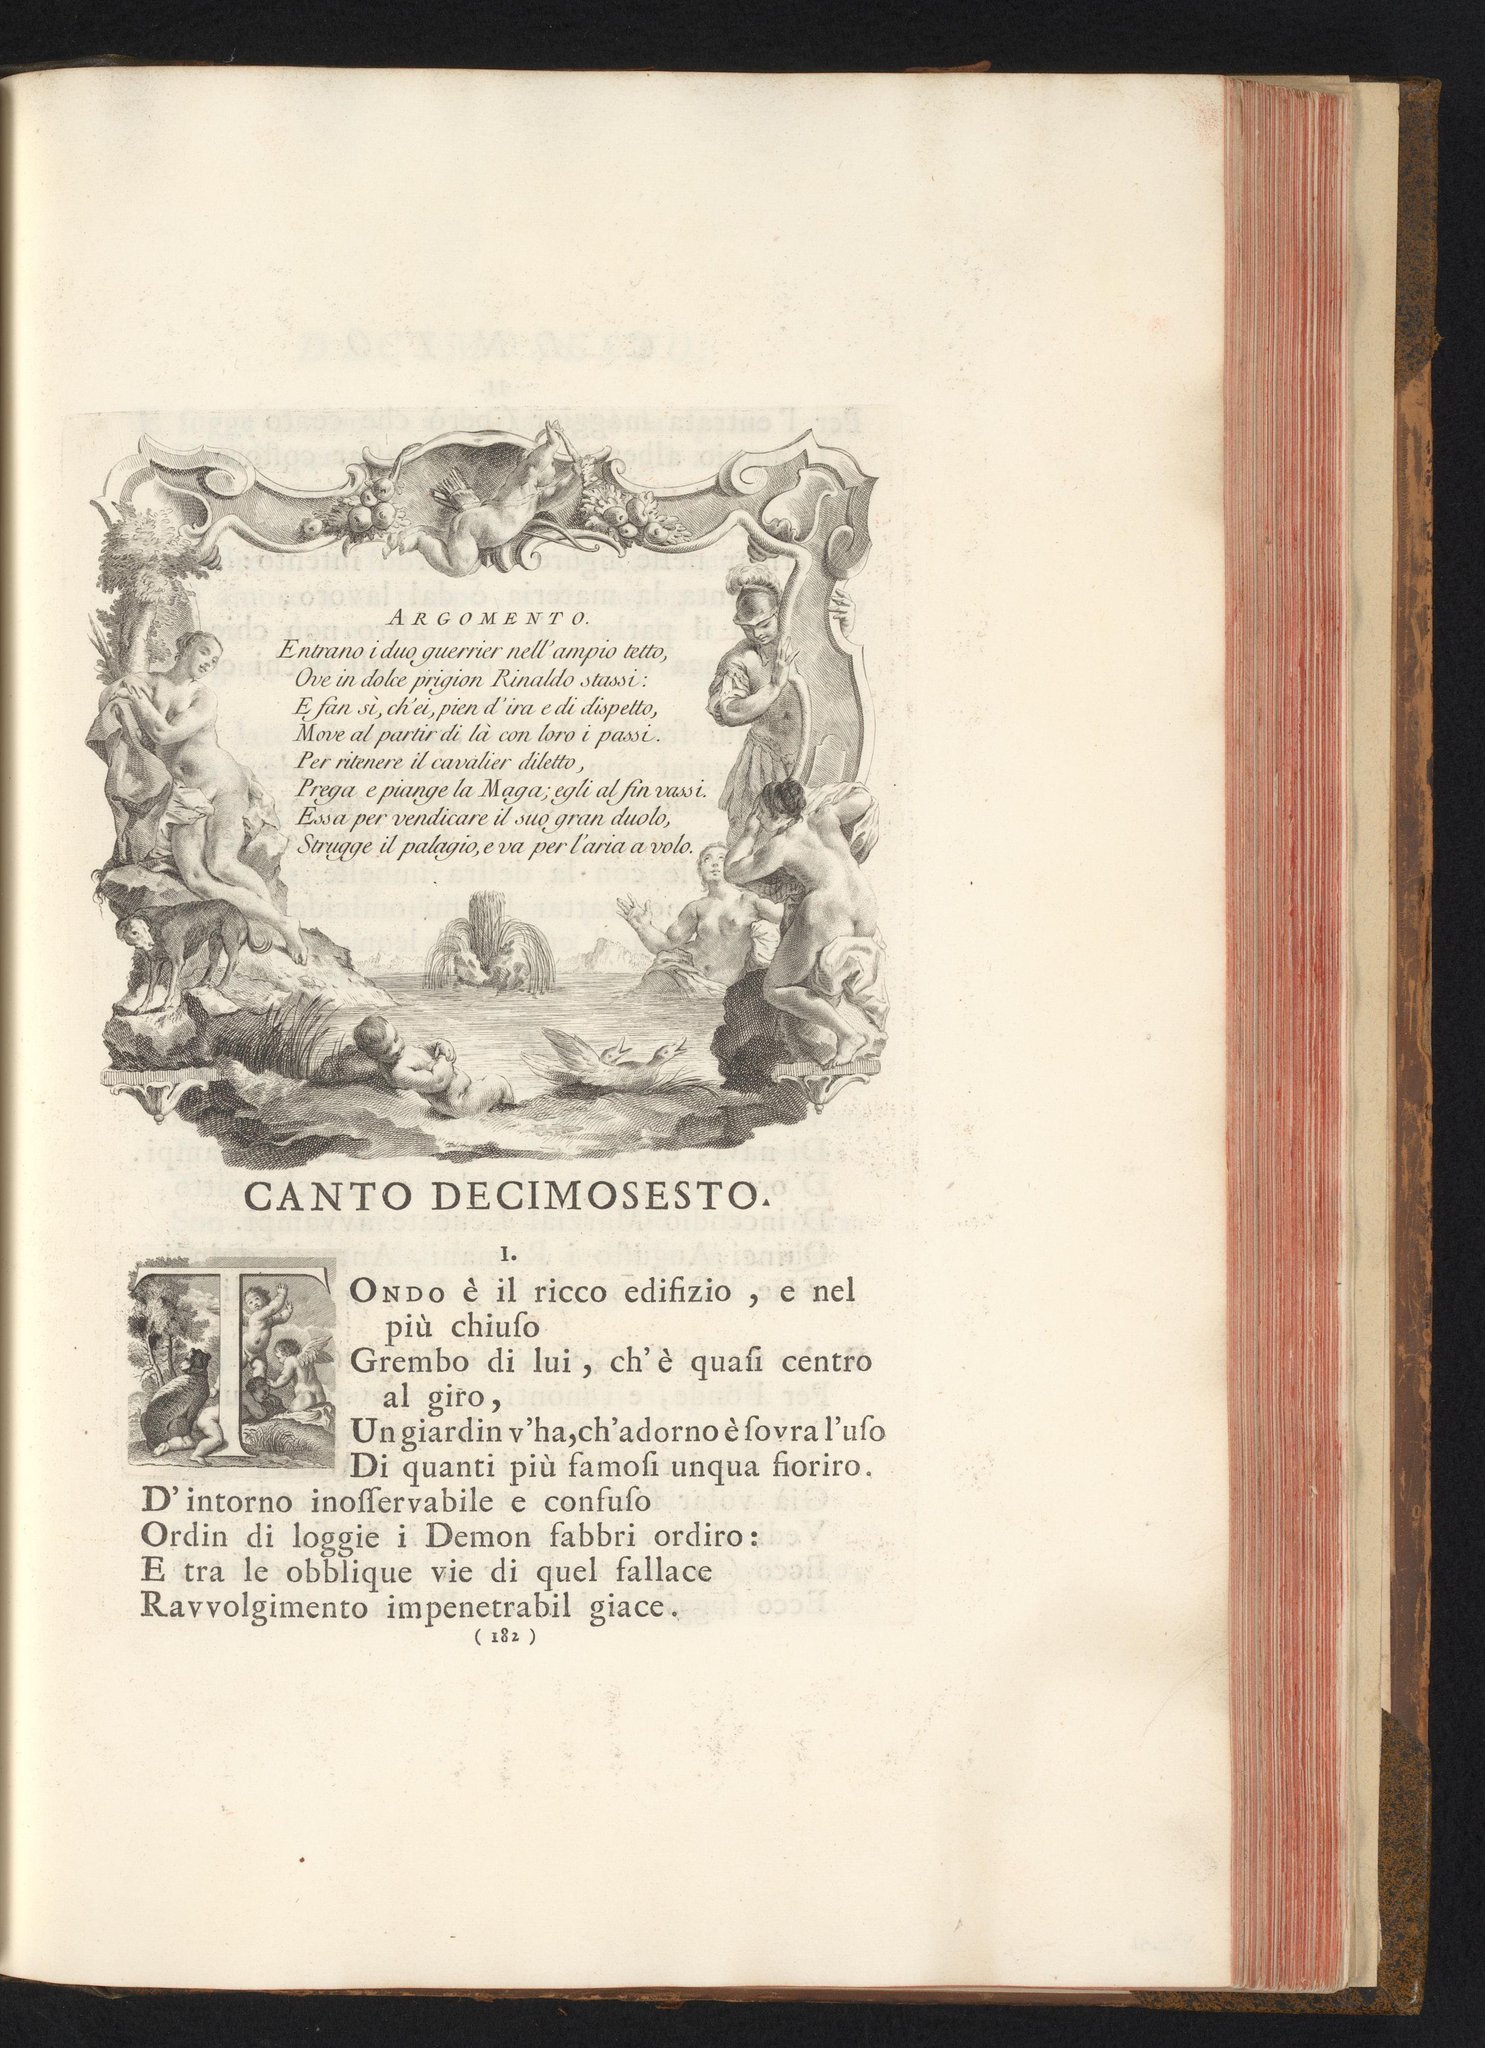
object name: print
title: Kustlandschap met figuren en initiaal T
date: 1745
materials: paper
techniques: etching, letterpress printing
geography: venice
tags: initial, (scenes from) specific works of literature: tasso, gerusalemme liberata, coast (+ landscape with figures, staffage)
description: Prent uit: Tasso, Torquato. La Gerusalemme liberata di Torquato Tasso con le figure de Giambatista Piazzetta. Venetië: Giambatista Albrizzi, 1745.